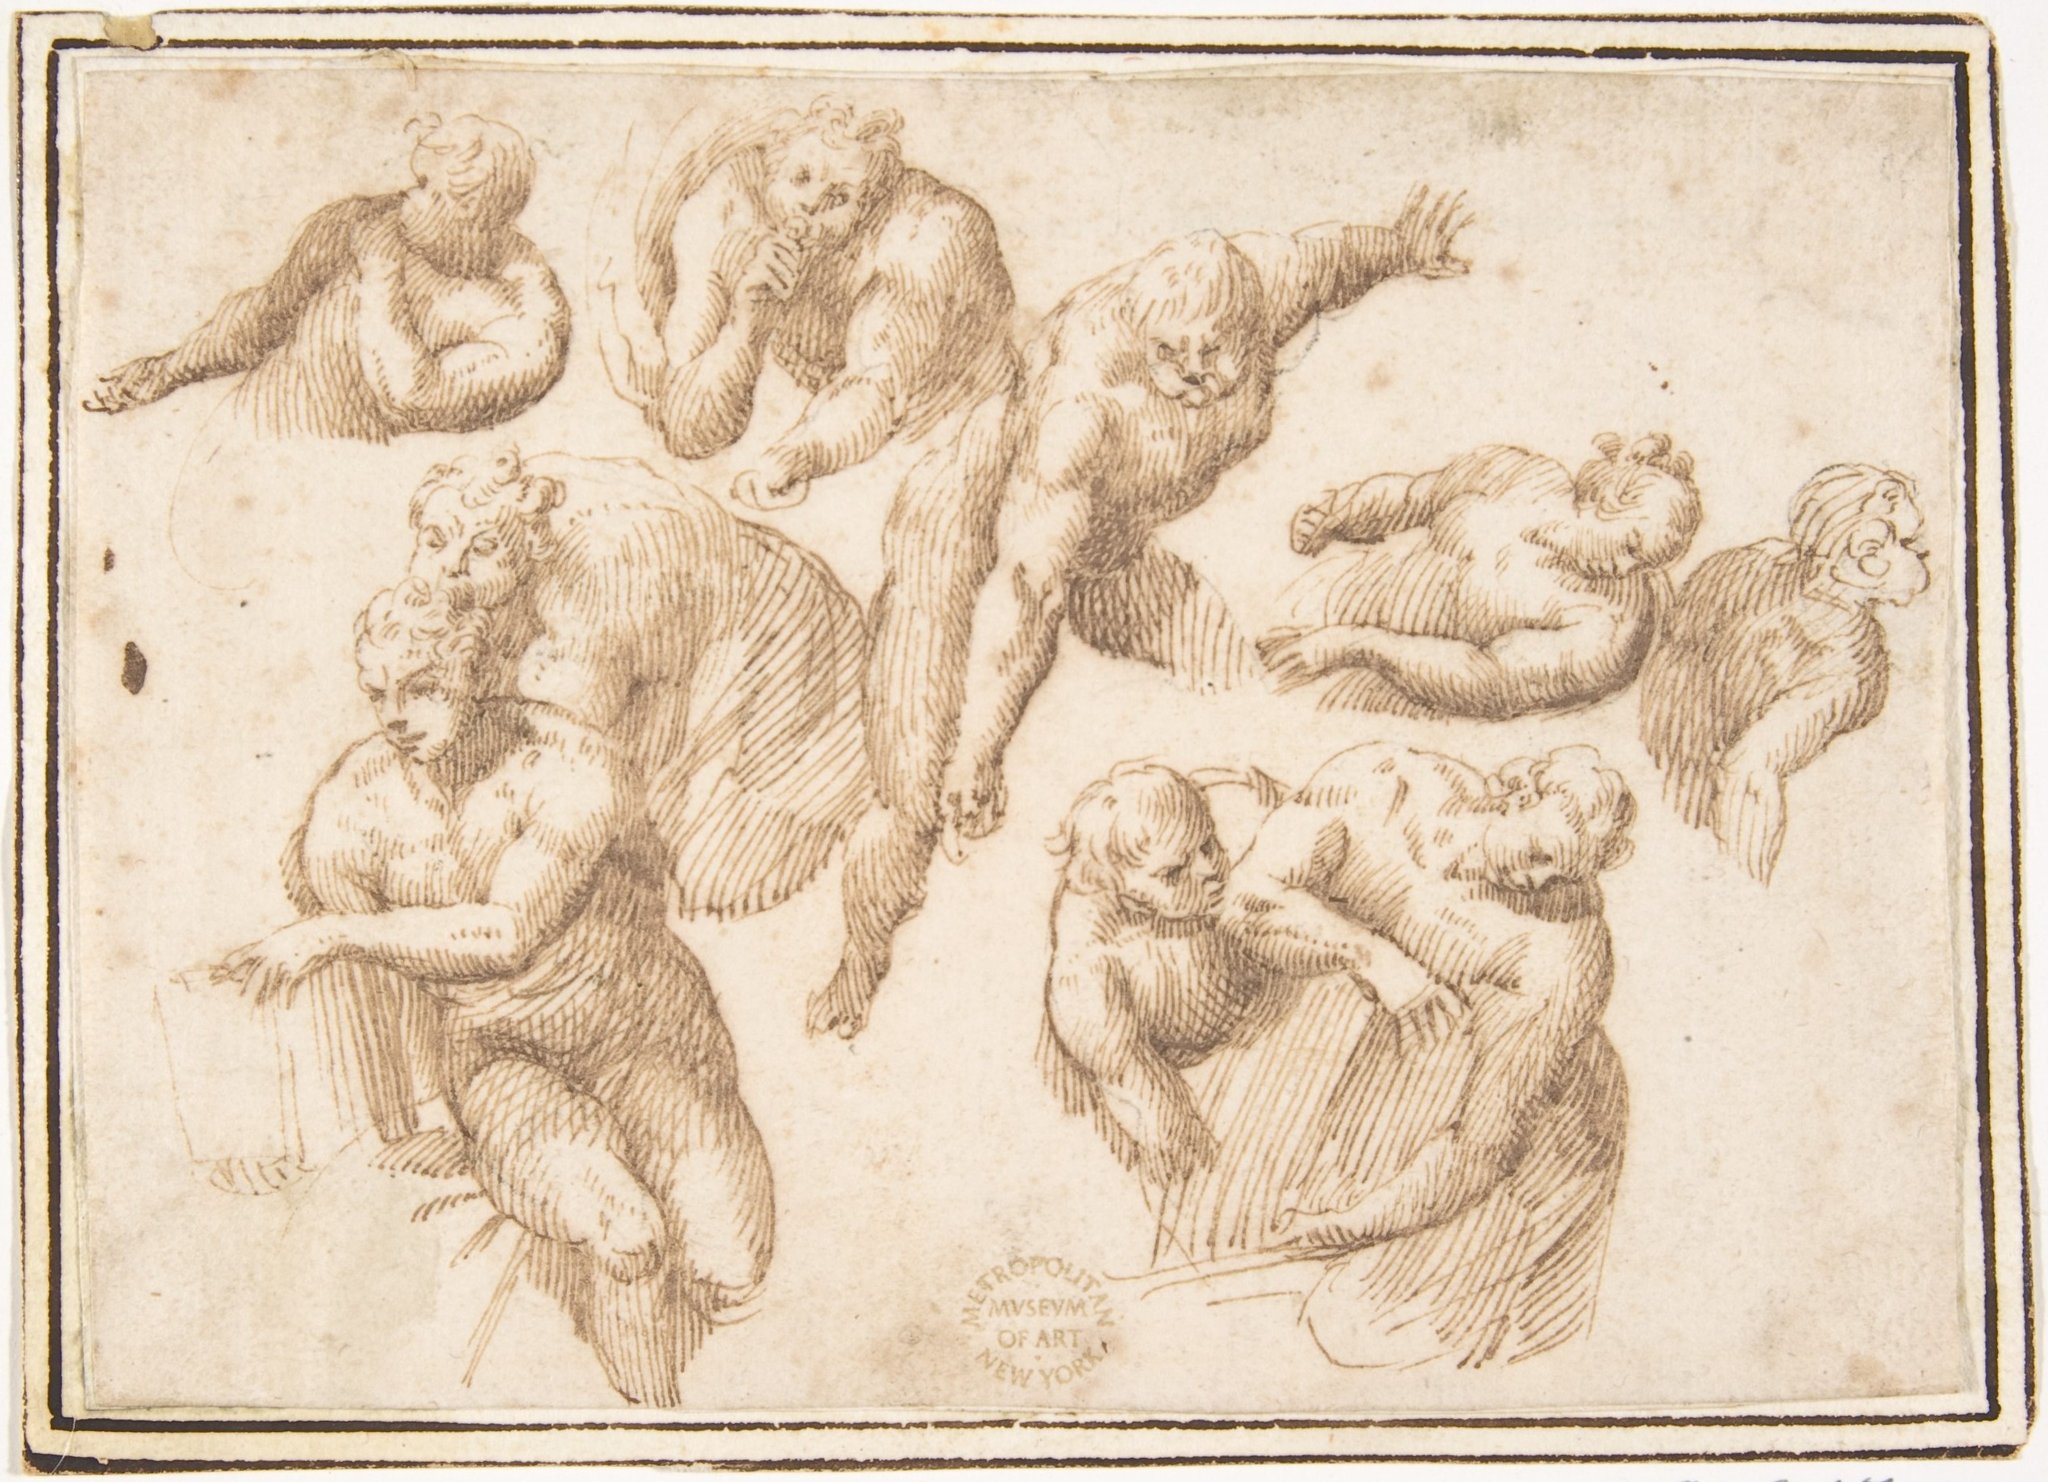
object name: drawing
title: Group of Figures Copied from Michelangelo's Last Judgment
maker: francesco allegrini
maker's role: artist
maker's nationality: italian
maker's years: 1615-1679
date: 1624-1663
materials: chalk, ink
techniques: pen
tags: human figures